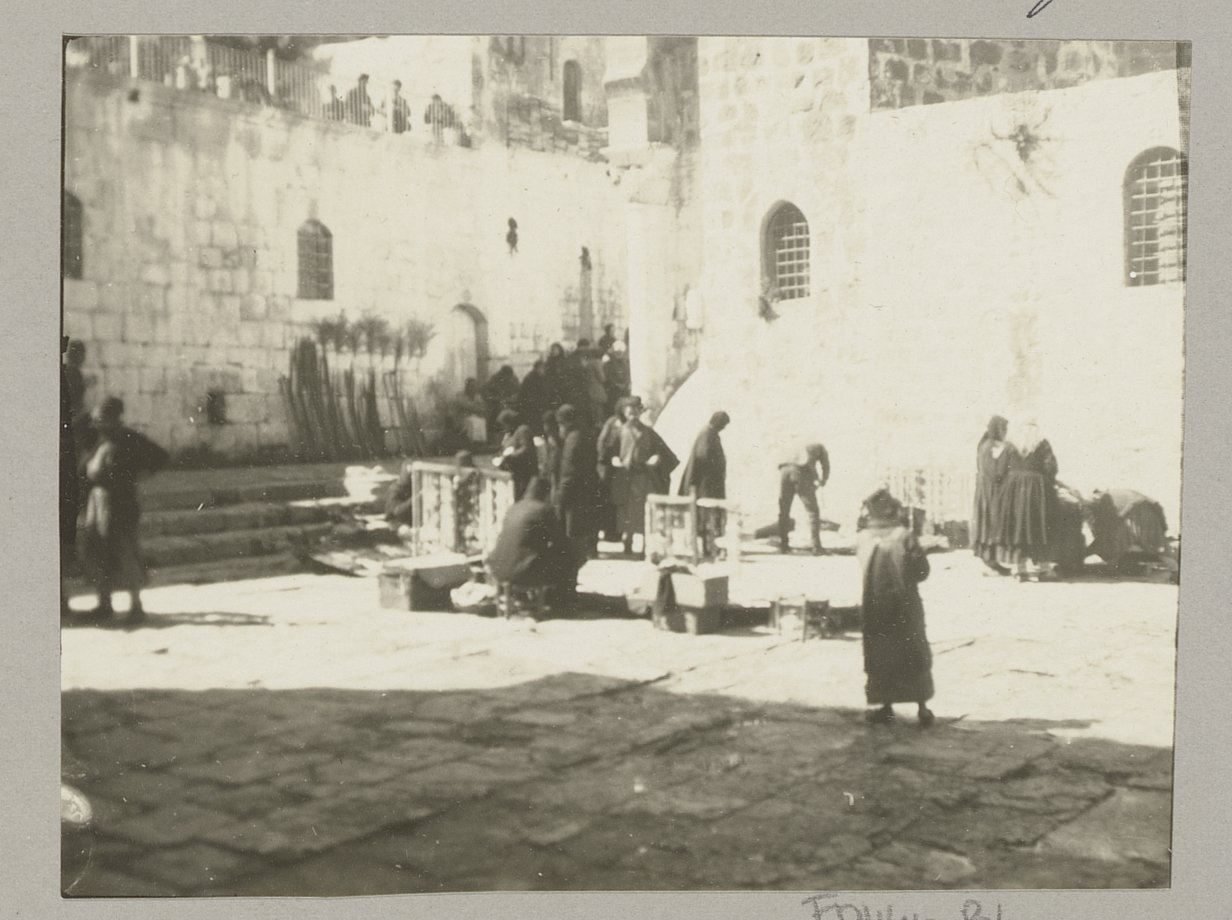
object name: photograph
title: Plein voor de Heilig-Grafkerk in Jeruzalem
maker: Anonymous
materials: photographic support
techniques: gelatin silver print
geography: jerusalem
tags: square, place, circus, etc. (+ city(-scape) with figures, staffage)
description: Onderdeel van Fotoalbum van een reis door Zuid-Europa en het Midden-Oosten.